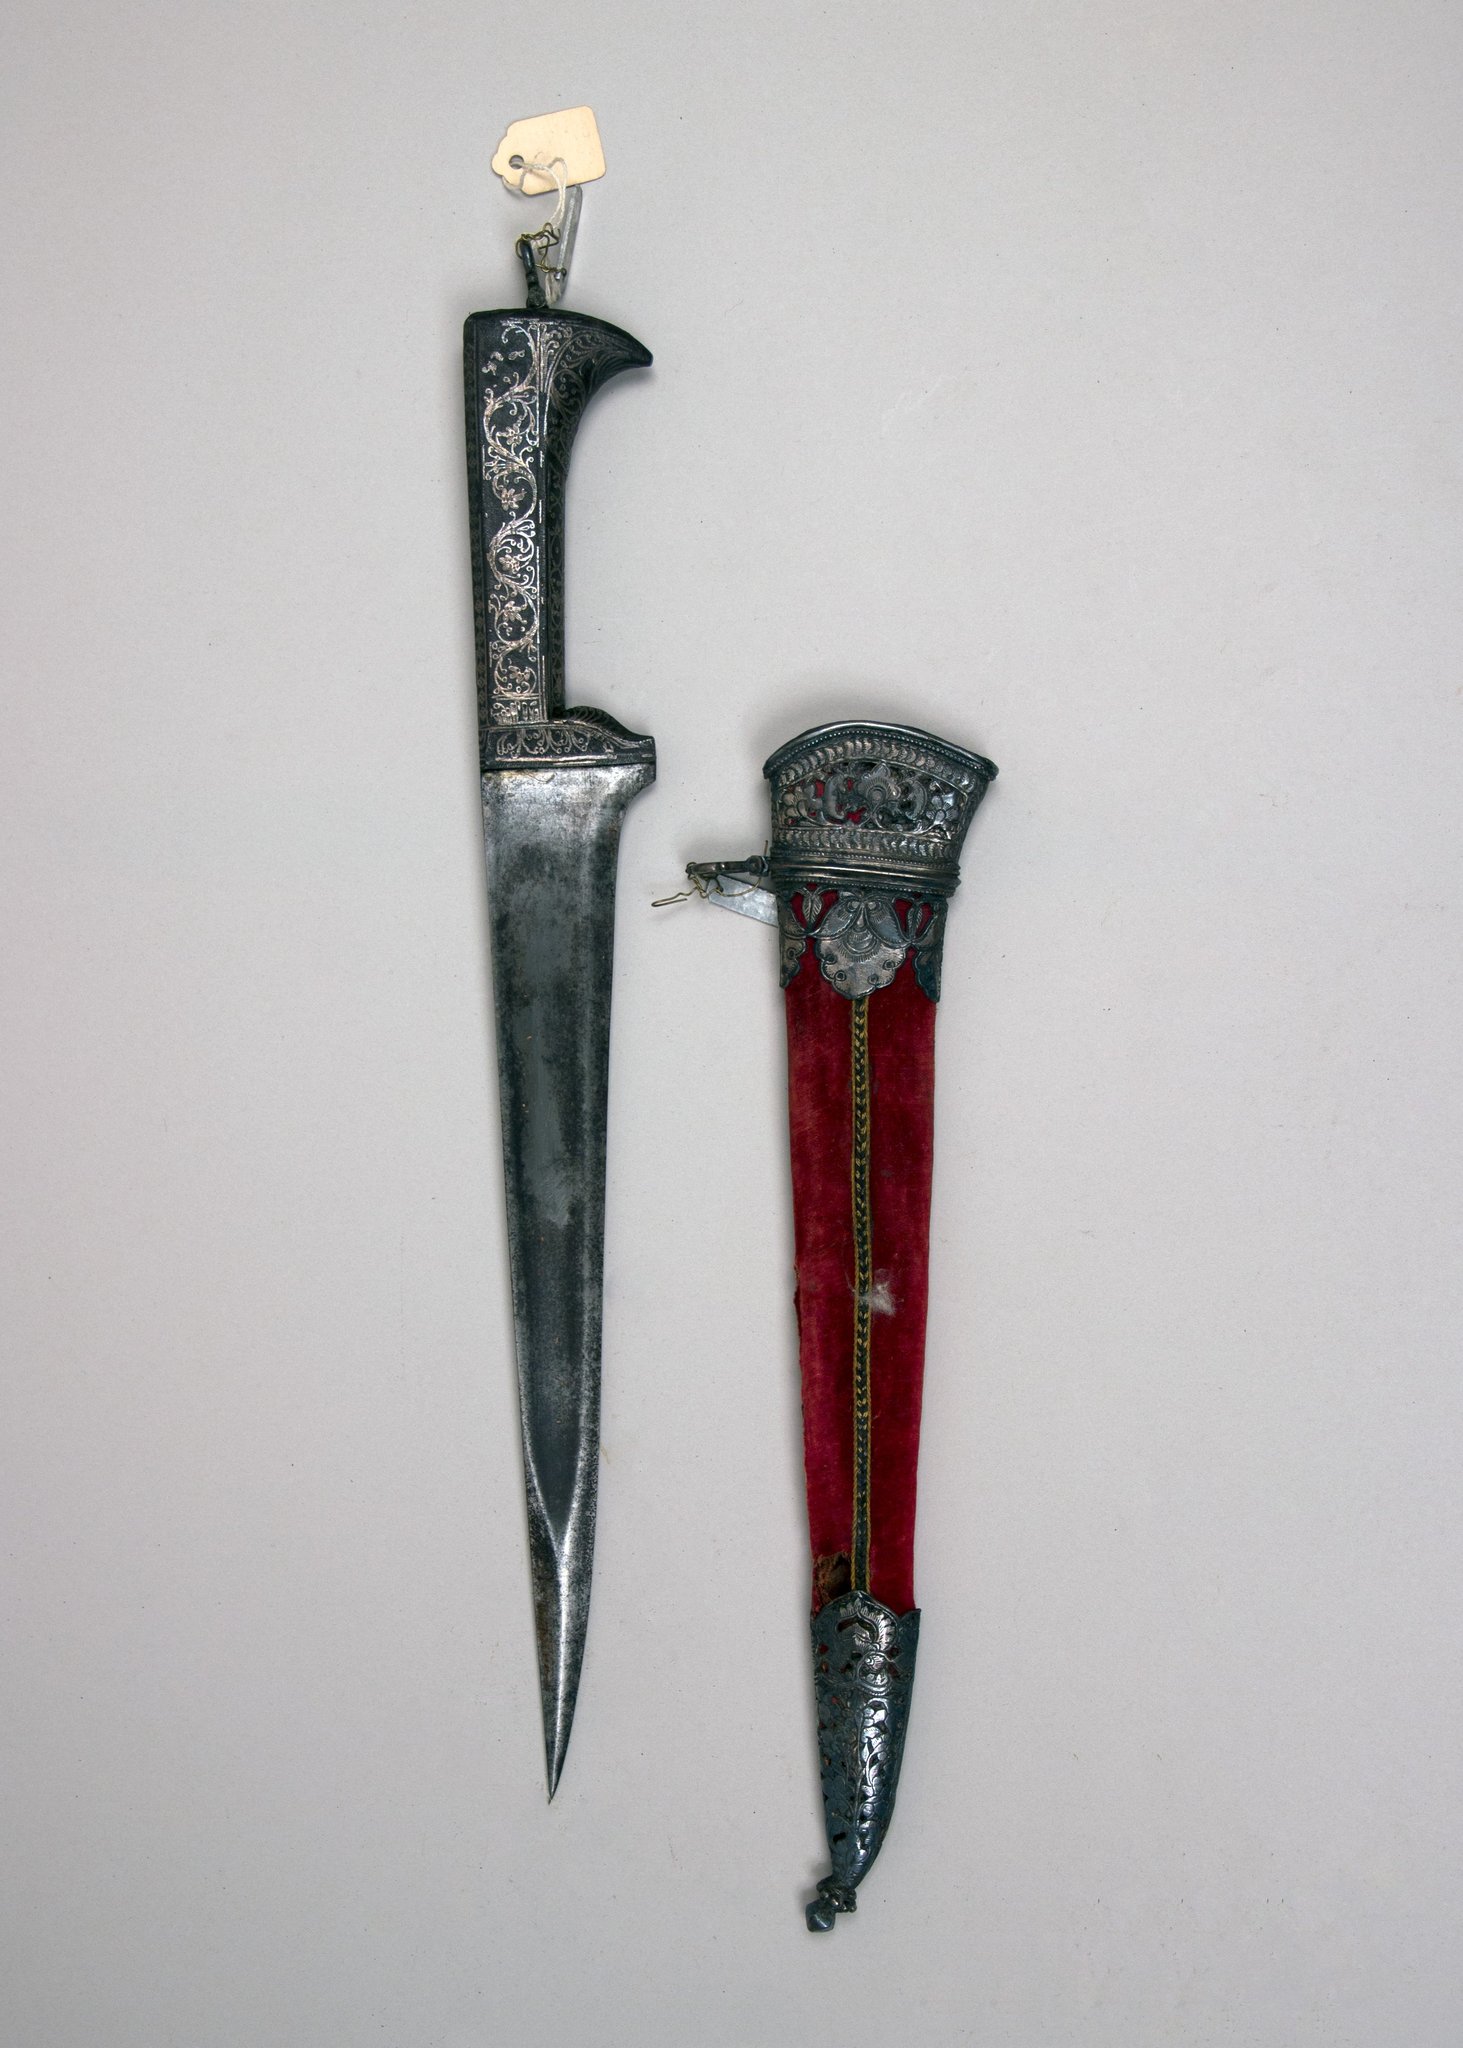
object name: dagger pesh kabz with sheath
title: Dagger (Pesh-Kabz) with Sheath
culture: persian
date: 1801-1900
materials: silver, steel, velvet, wood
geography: iran